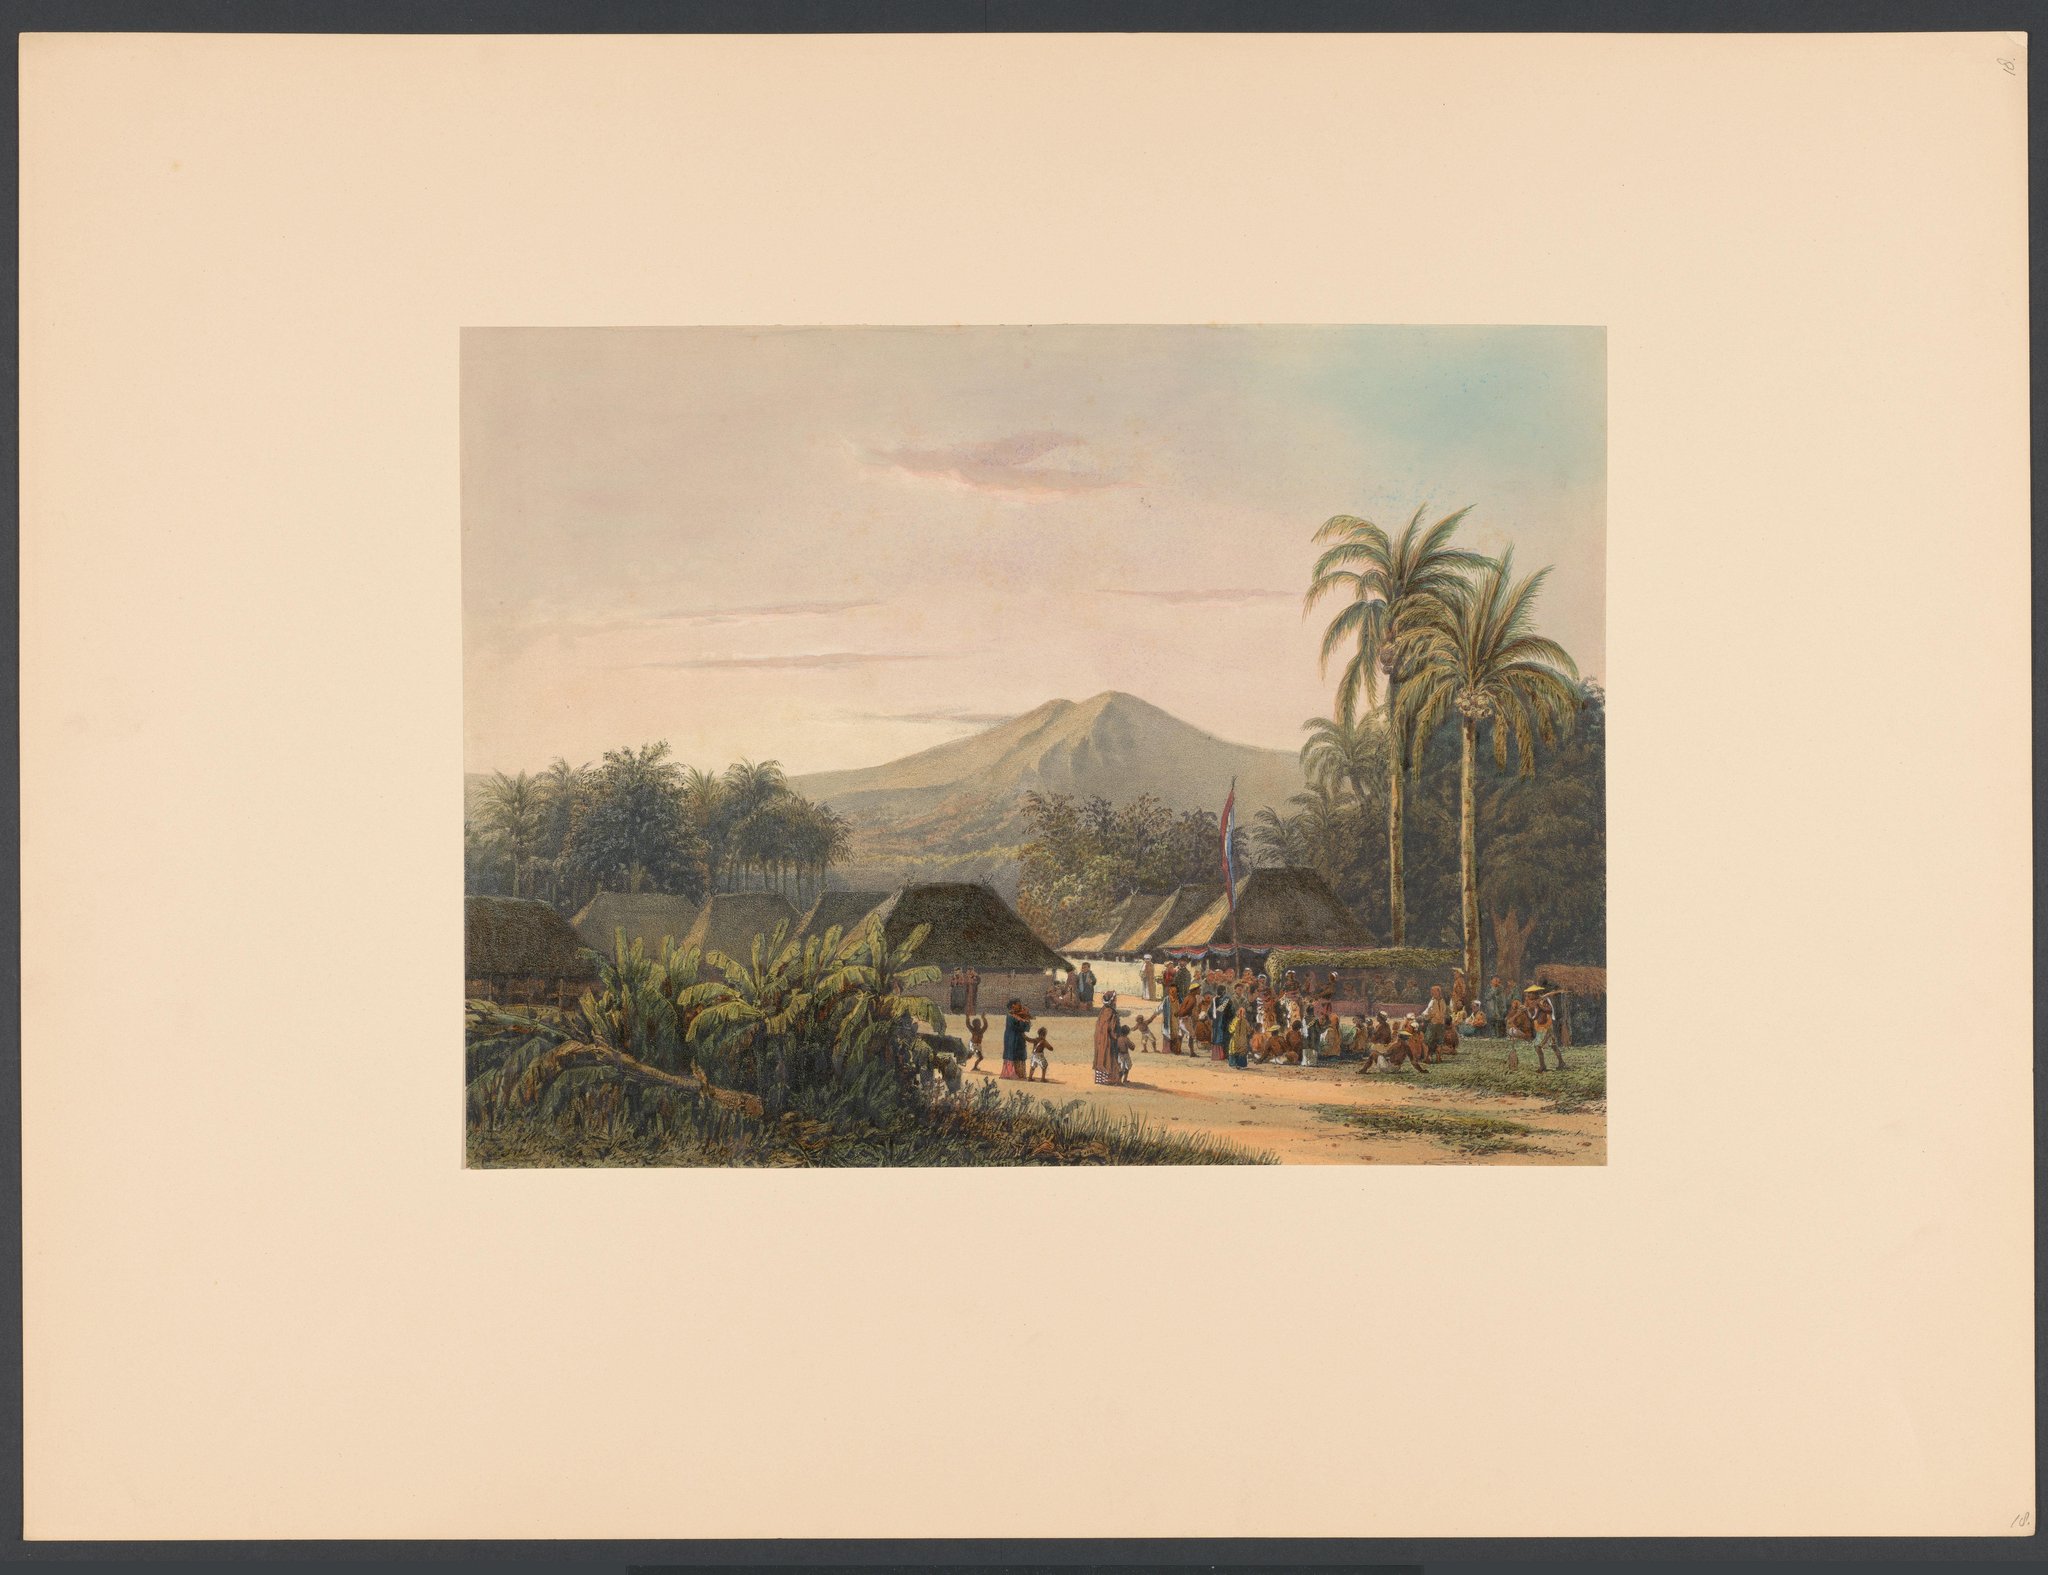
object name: print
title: Dorpsfeest nabij de Ardjoeno berg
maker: johan conrad greive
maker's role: draughtsman, painter, print maker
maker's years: 1837-1891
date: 1865-1872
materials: paper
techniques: lithograph, hand coloring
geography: amsterdam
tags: public festivities, group dancing, mountains, surabaya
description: Volgens de bijbehorende inhoudsopgave betreft dit de 18de prent uit de reeks van 24.